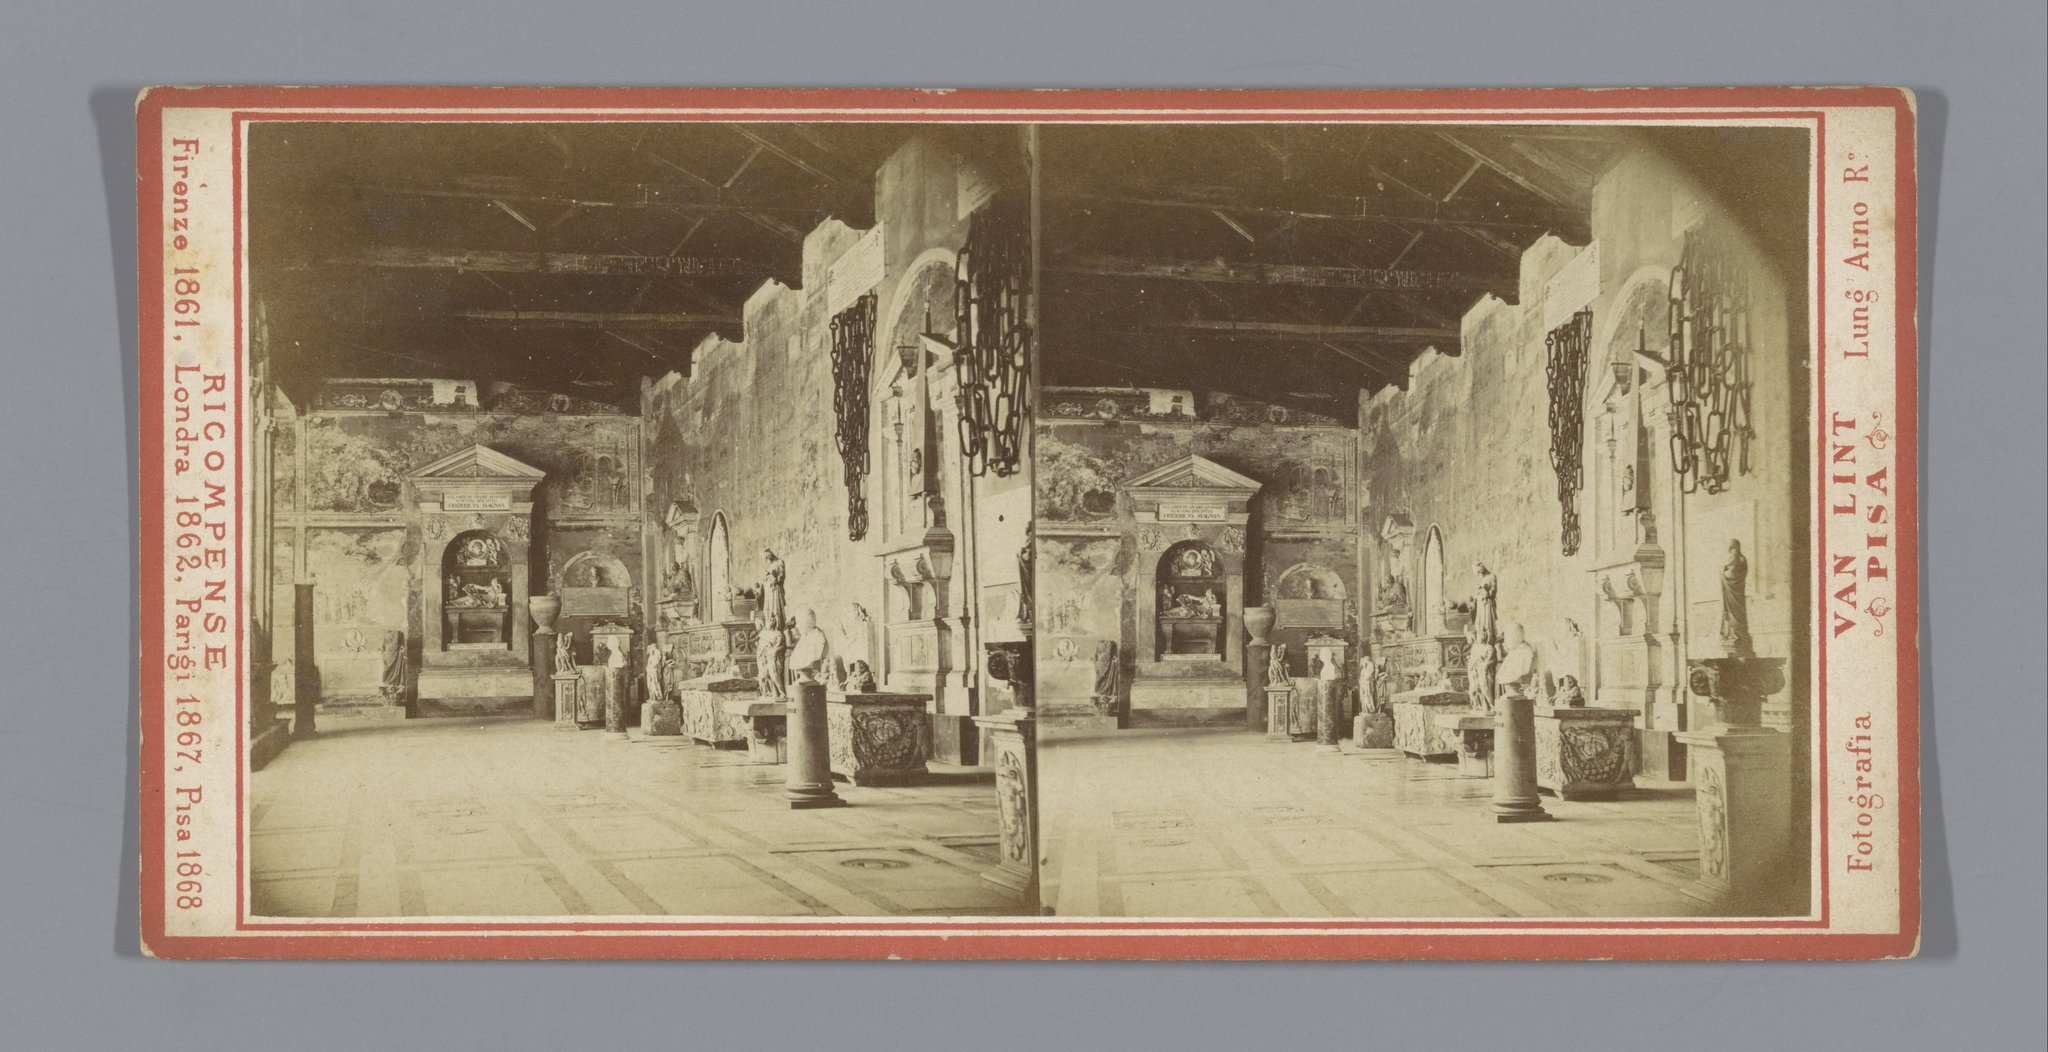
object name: stereograph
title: Interieur van het Camposanto te Pisa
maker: enrico van lint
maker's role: fotograaf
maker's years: 1808-1884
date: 1850-1880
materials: cardboard, photographic support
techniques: albumen print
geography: pisa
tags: grave, tomb, interior ~ representation of a building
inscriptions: name: ‘Fotografia VAN LINT PISA Lung Arno Ro. RICOMPENSE Firenze 1861, Londra 1862, Parigi 1867, Pisa 1868’, inscription: ‘Campo Santo of Kerkhof te Pisa met de Ketting waarmee de haven van Pisa vroeger gesloten en laatst door Genua zijn teruggegeven’